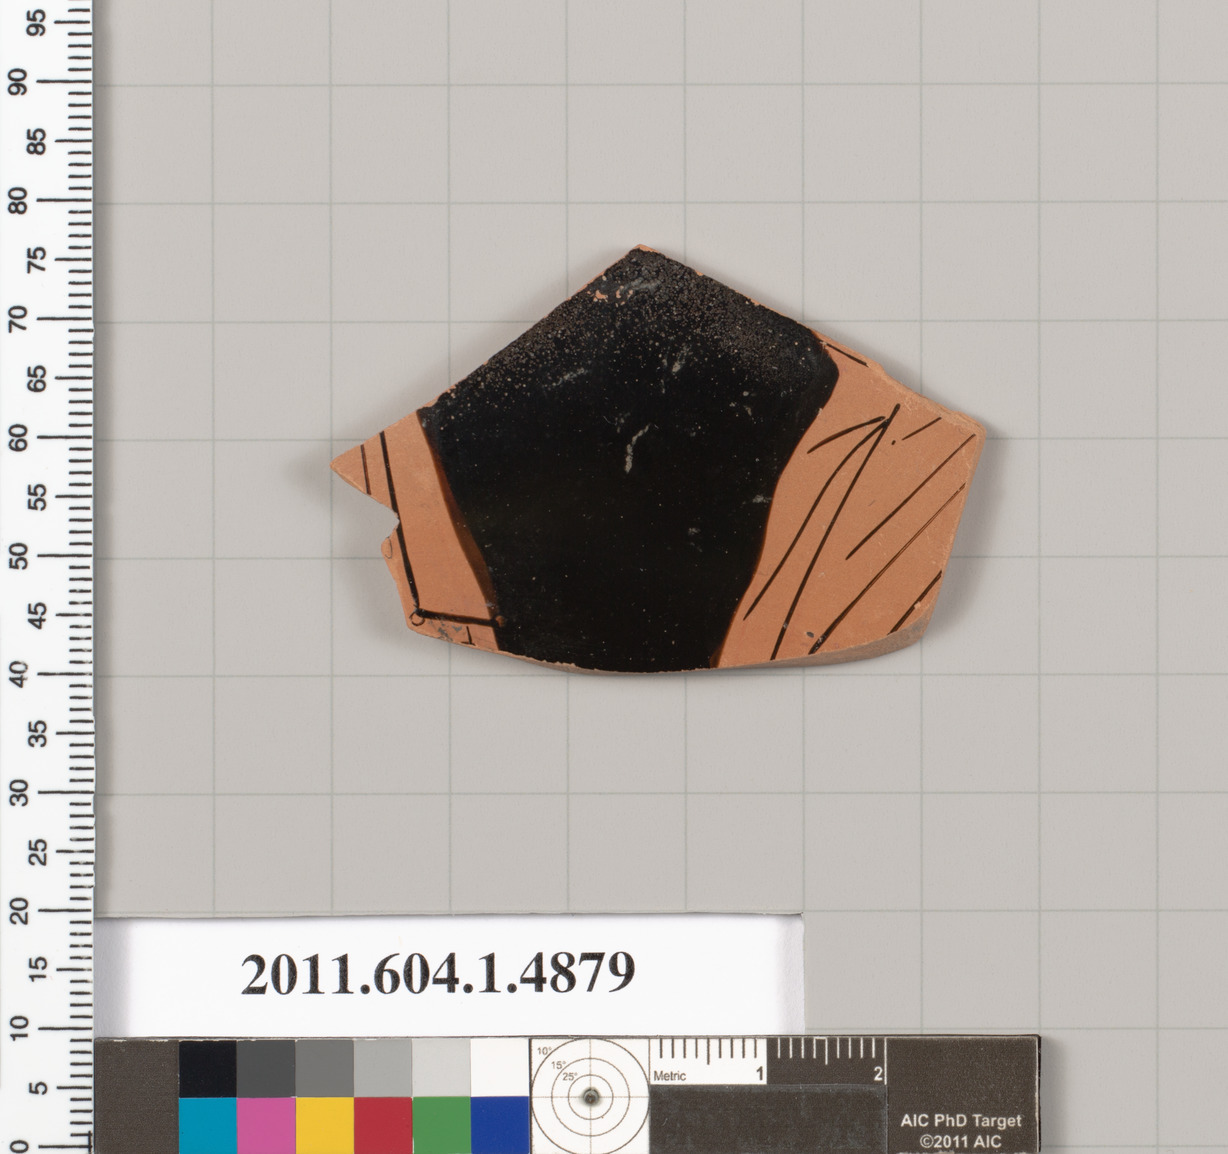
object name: kylix fragment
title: Terracotta fragment of a kylix (drinking cup)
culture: greek, attic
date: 475-451 BCE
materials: terracotta